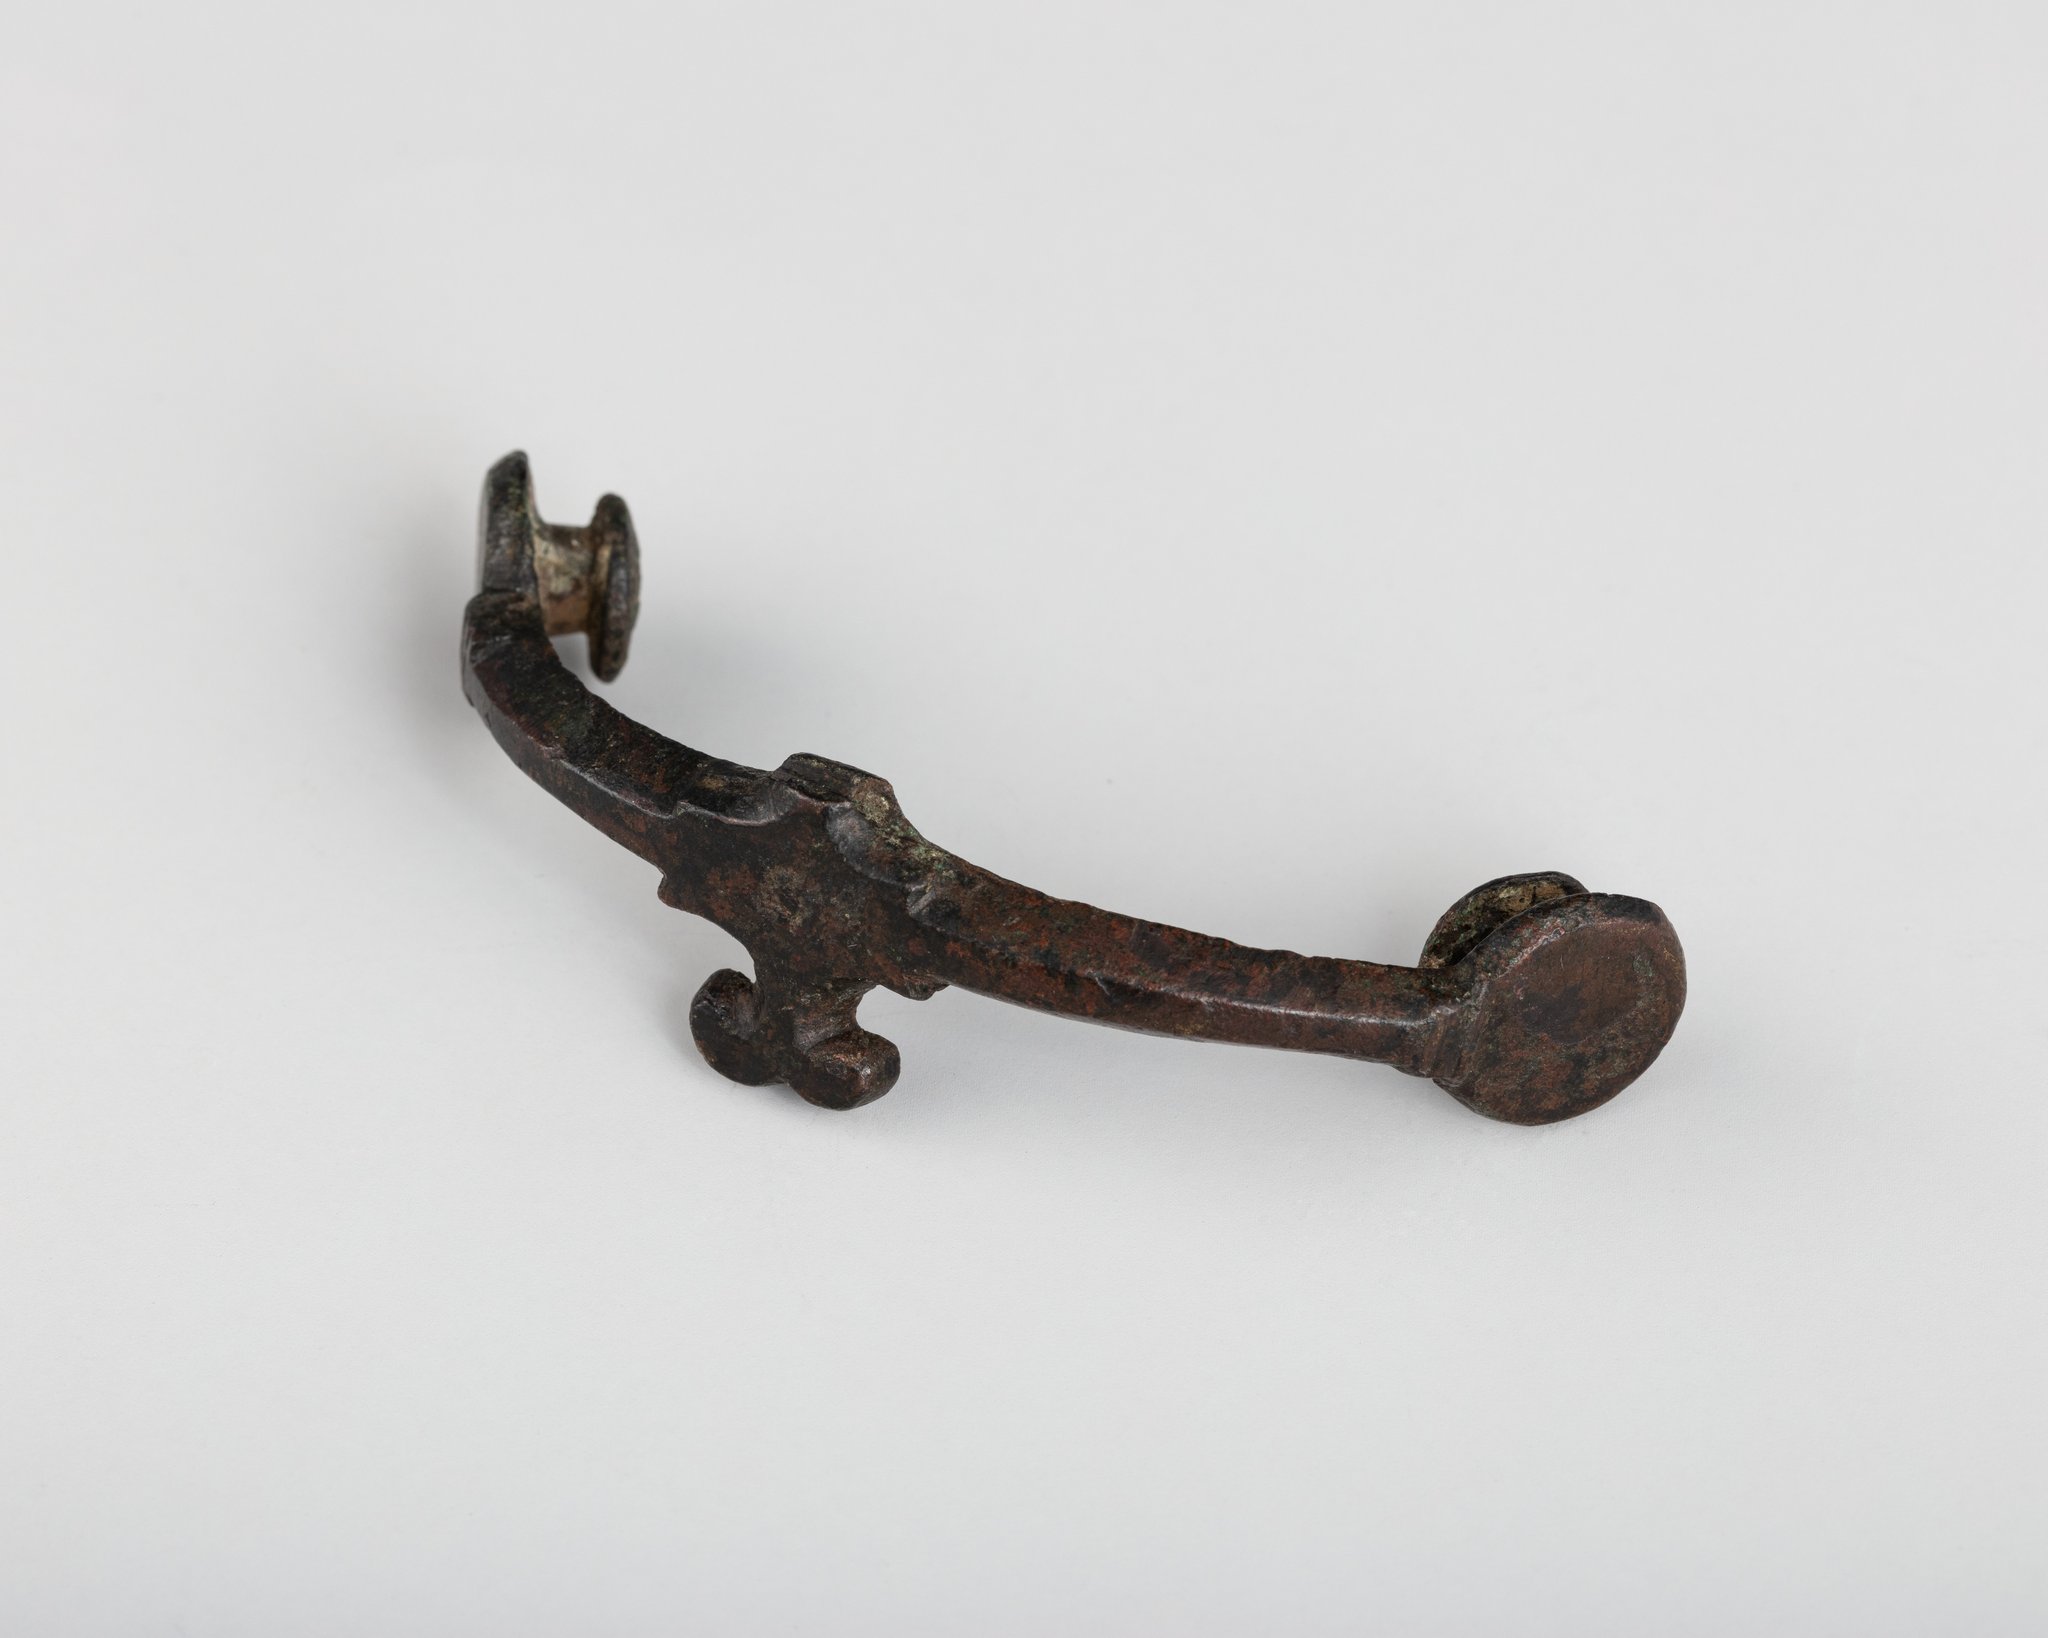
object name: spur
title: Prick Spur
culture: gallo-roman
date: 101-400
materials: copper alloy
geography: germany